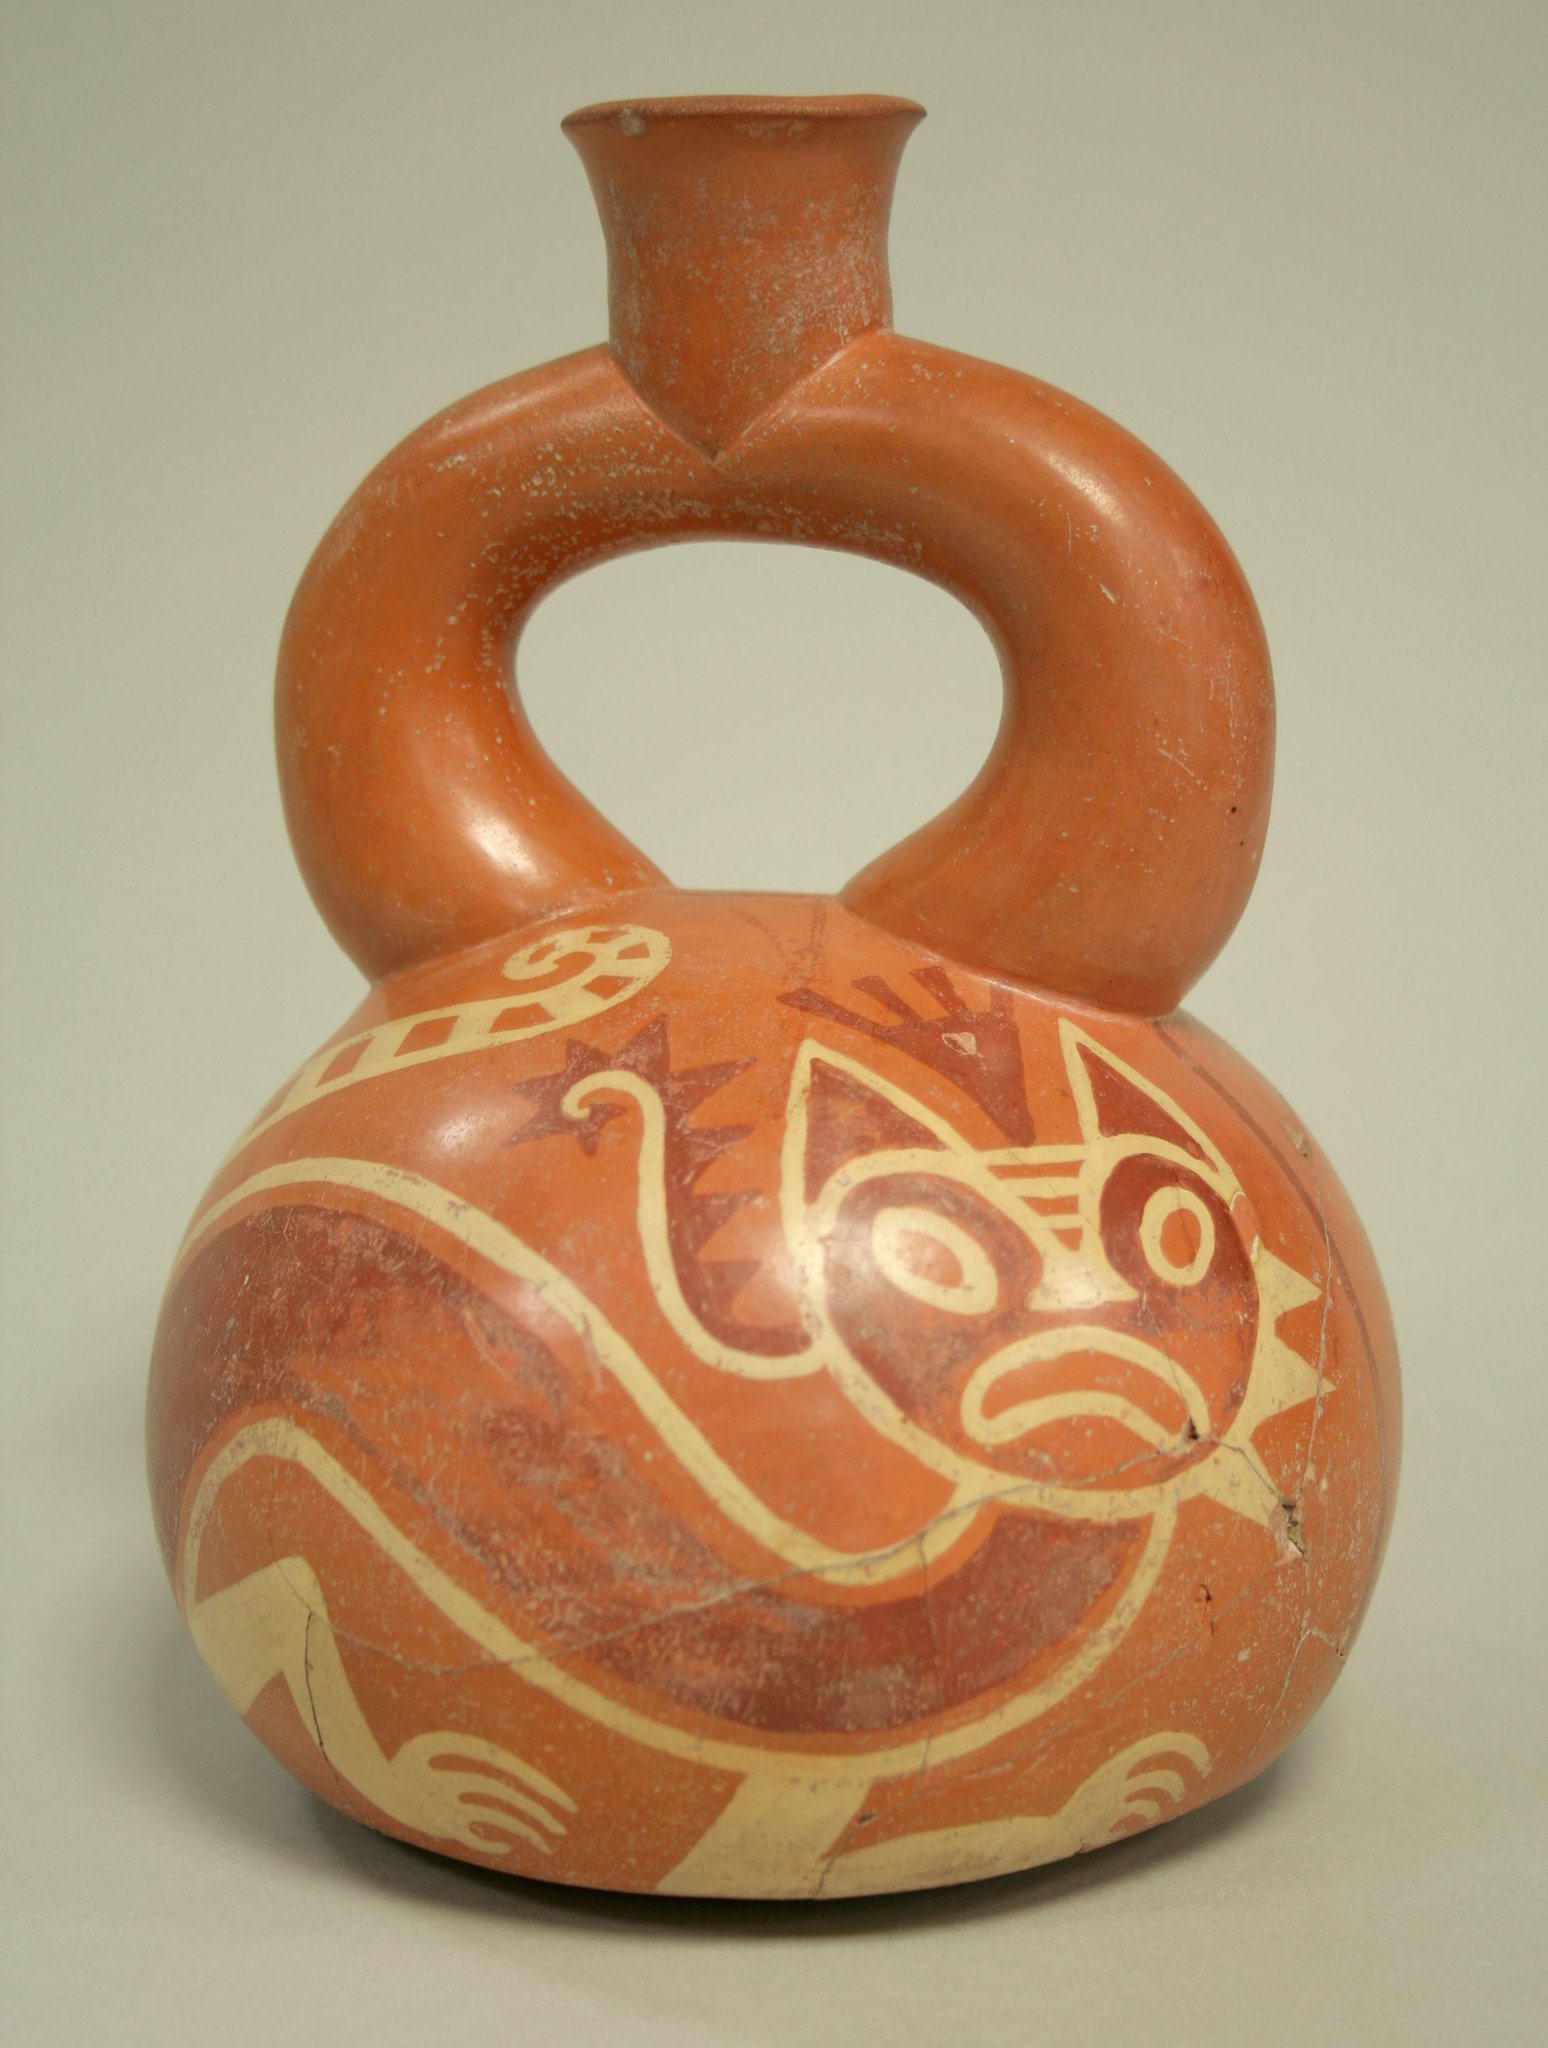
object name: bottle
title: Stirrup Spout Bottle with Felines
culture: salinar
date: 100 BCE-200 CE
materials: ceramic, pigment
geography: peru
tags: animals